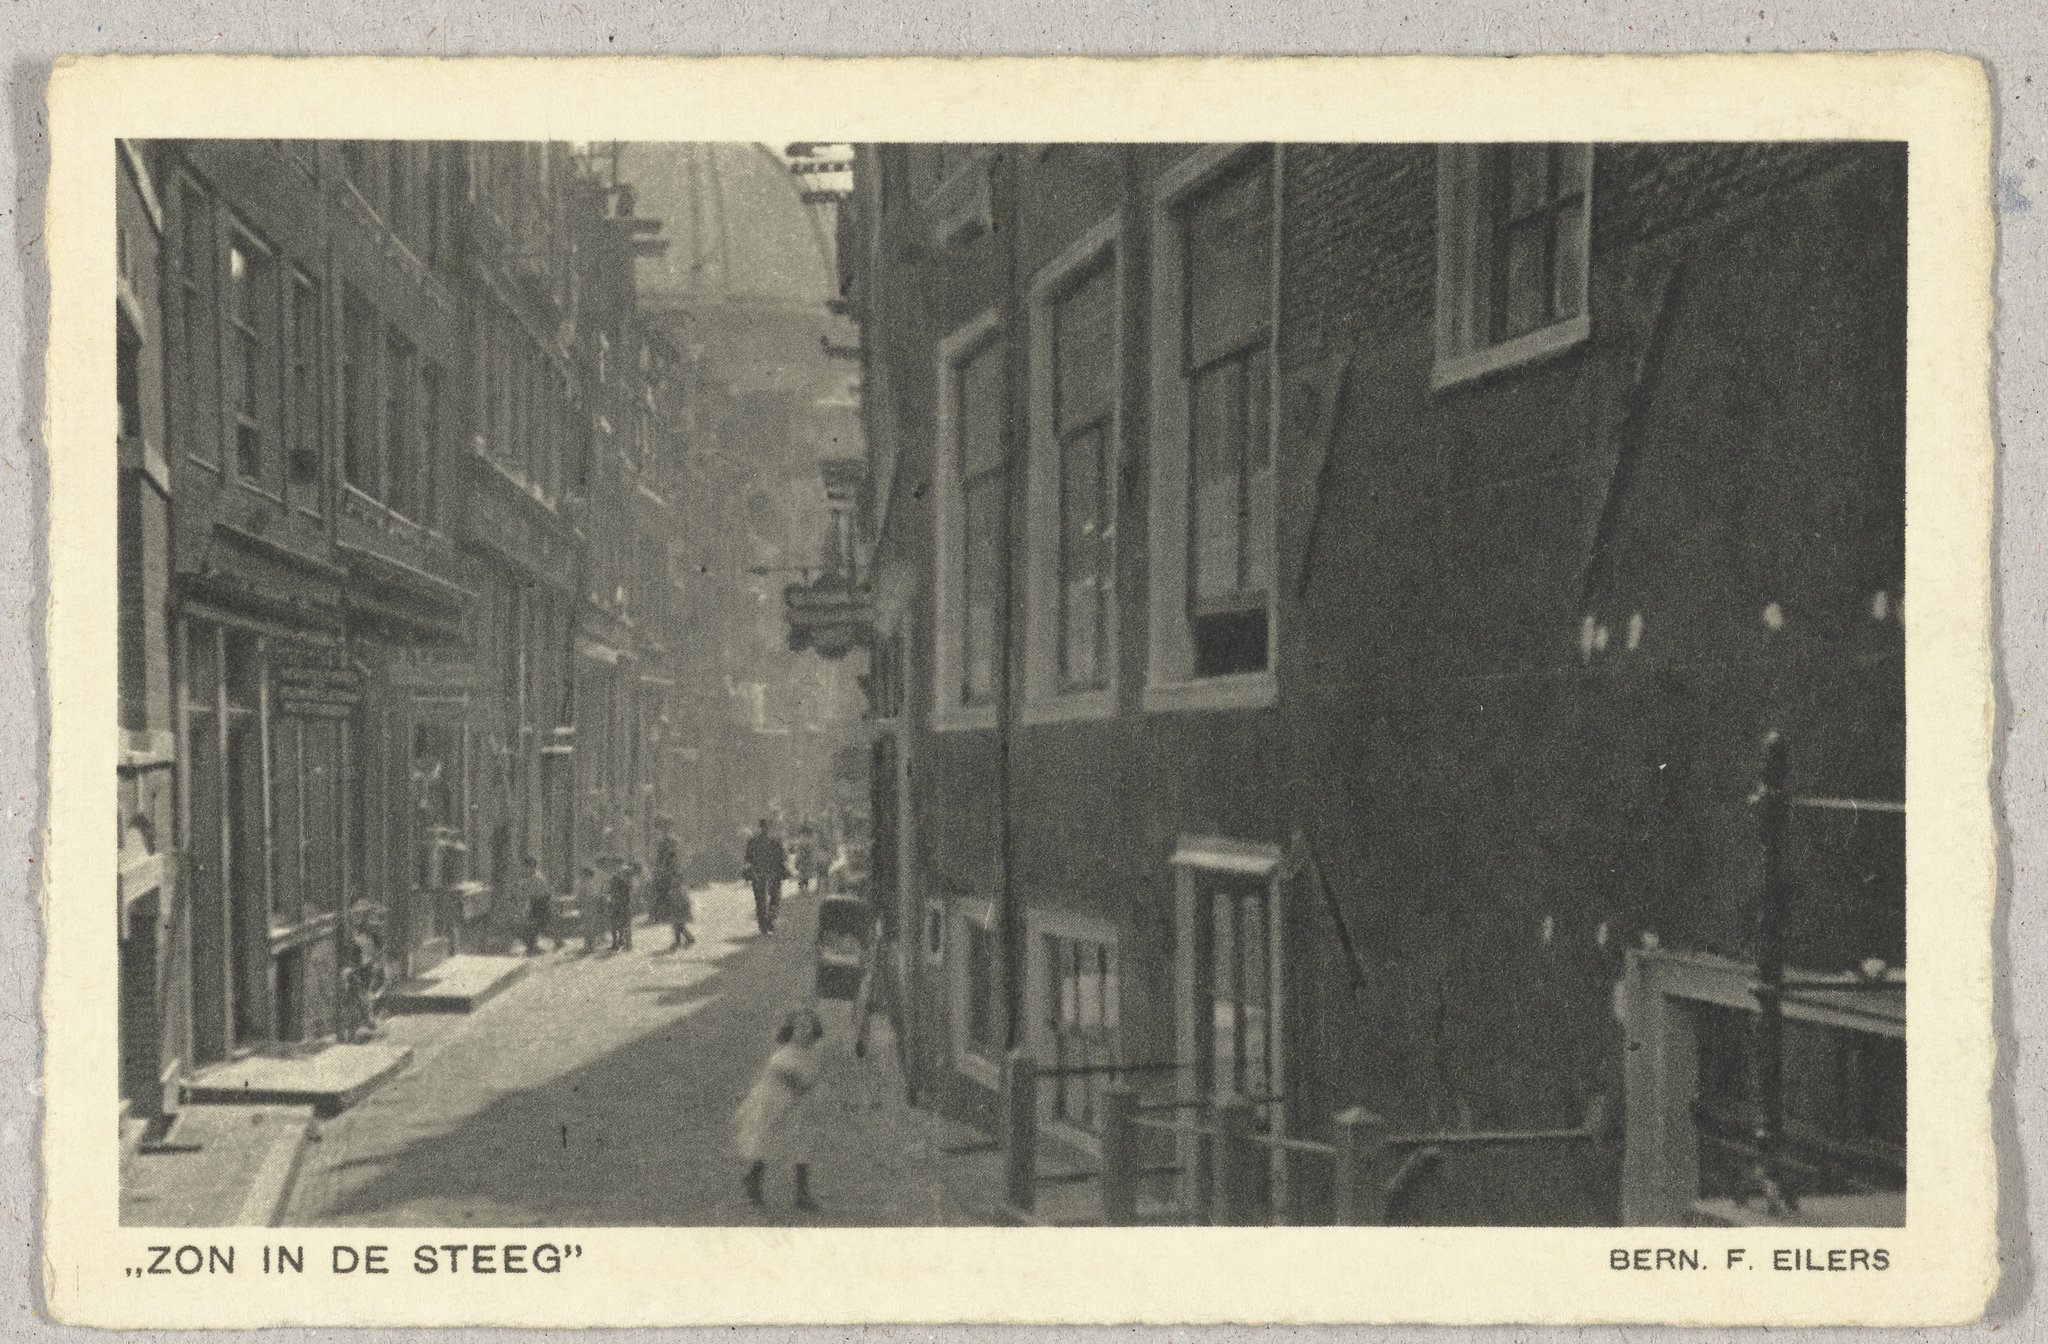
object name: ansichtkaart, prentbriefkaart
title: Smaksteeg, Amsterdam ("Zon in de steeg")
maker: bernard eilers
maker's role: fotograaf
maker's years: 1878-1951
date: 1913-1940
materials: paper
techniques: rotogravure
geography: amsterdam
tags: street (+ city(-scape) with figures, staffage)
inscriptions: annotation: ‘serie: B, Amsterdam - Smaksteeg Amsterdam ("Zon in de steeg")’, name: ‘Bern. F. Eilers’, annotation: ‘Eilers Artistieke kaarten - uitg.-mij. "Kosmos" - Amsterdam’